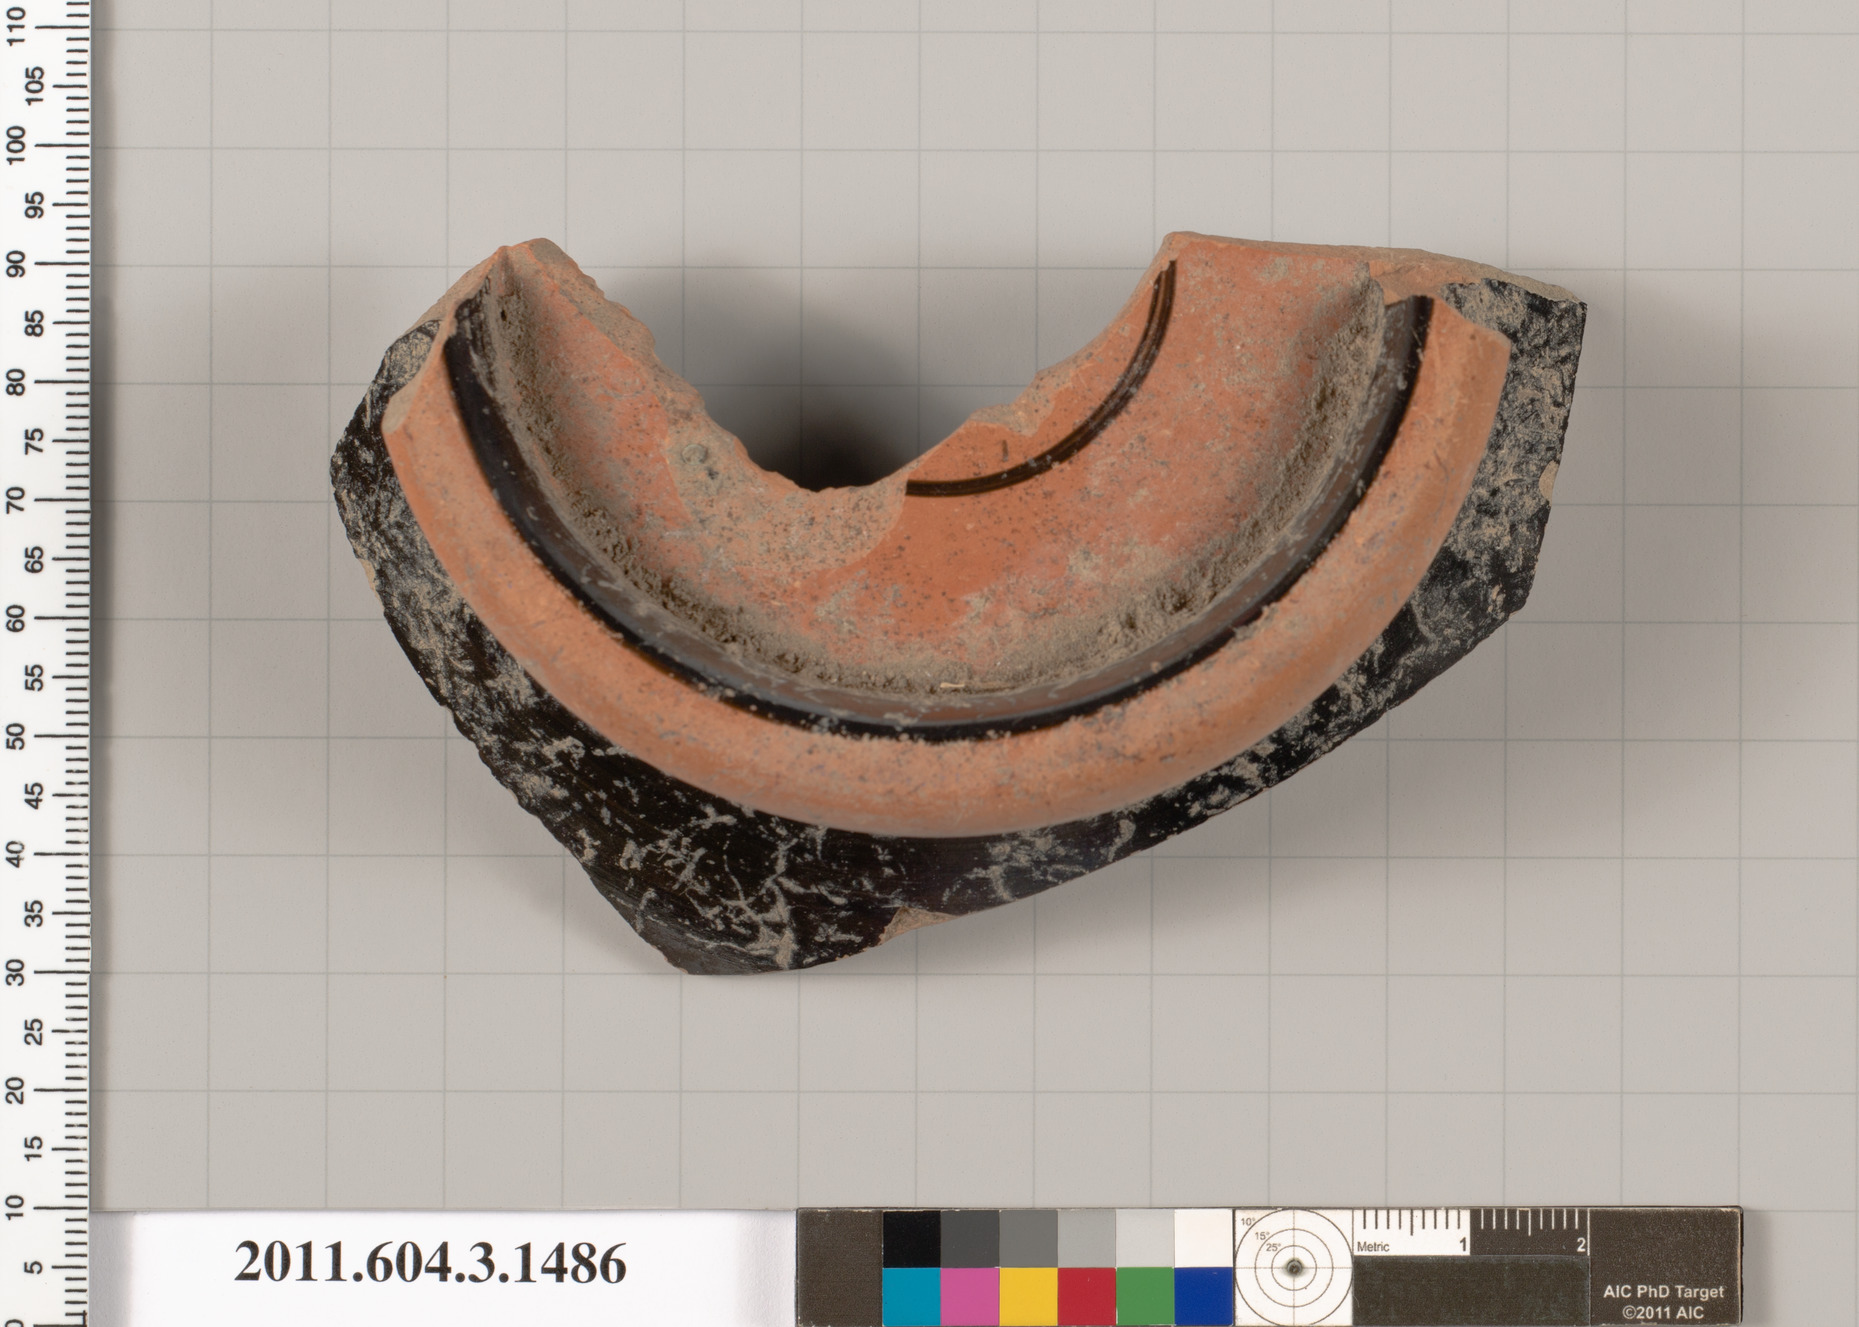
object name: skyphos fragment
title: Terracotta fragment of a skyphos (deep drinking cup)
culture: greek, attic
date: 600-401 BCE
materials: terracotta